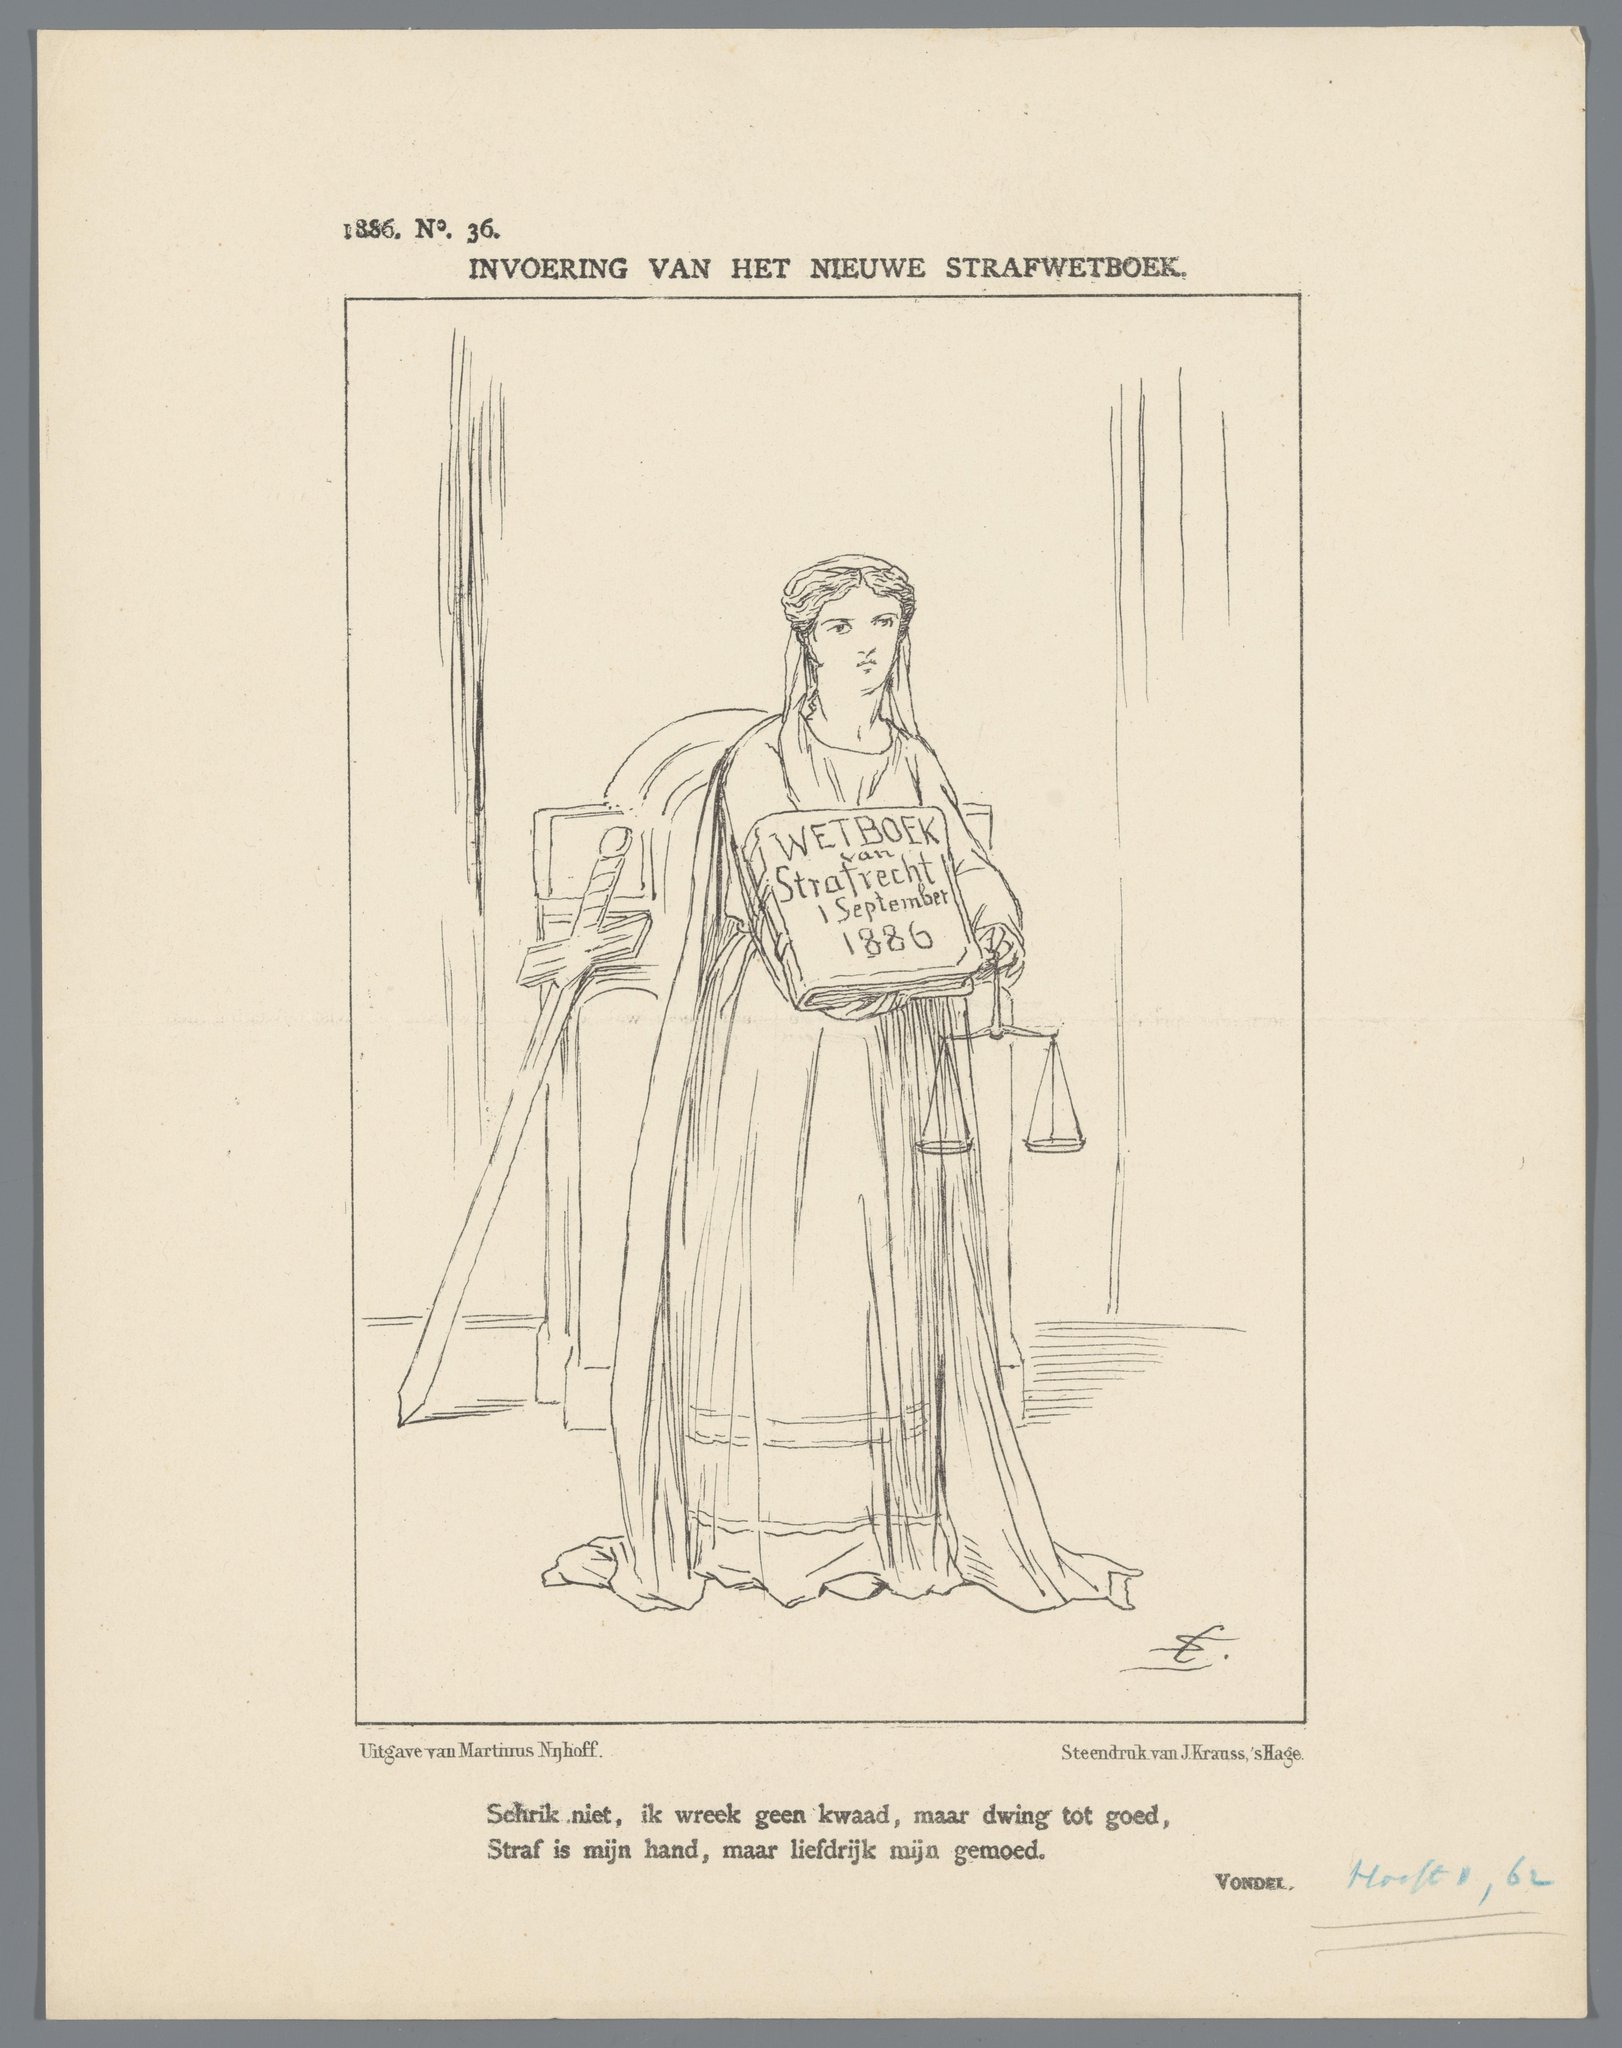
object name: cartoon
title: Spotprent bij het nieuwe wetboek van Strafrecht, 1 september 1886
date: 1886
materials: paper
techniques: lithograph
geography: the hague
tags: justice, 'justitia'; 'giustitia divina' (ripa) ~ one of the four cardinal virtues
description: Spotprent nav de invoering van het nieuwe wetboek van Strafrecht, 1 september 1886. Plaat verschenen bij het weekblad De Nederlandsche Spectator, nr. 36, 1886.